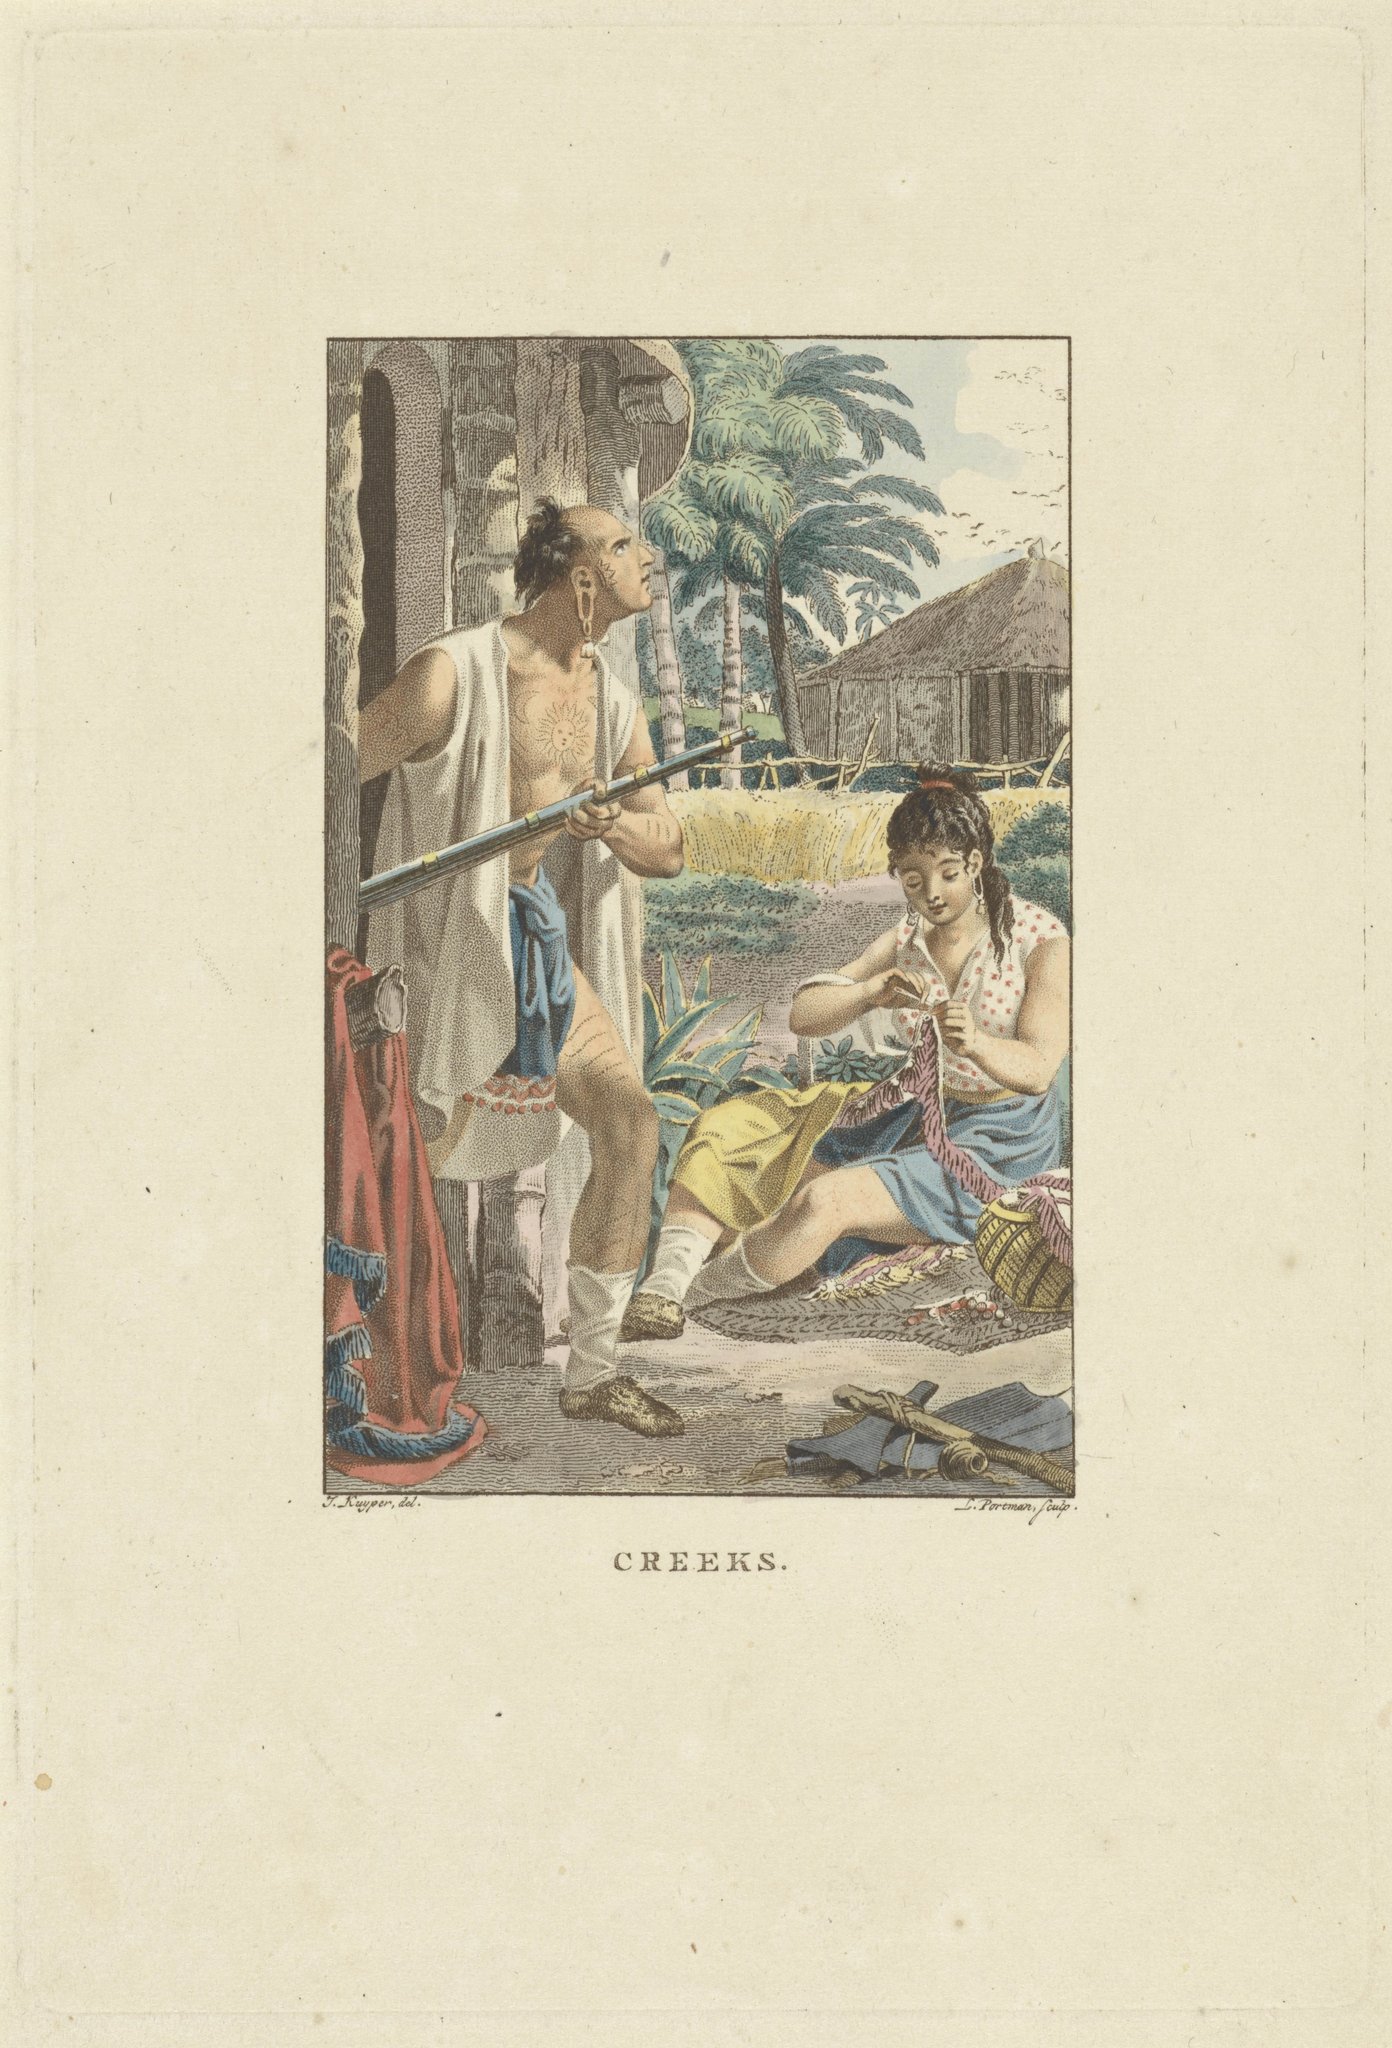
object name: book illustration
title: Echtpaar bij hun hut in het veld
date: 1805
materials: paper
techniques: brush, etching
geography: amsterdam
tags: indigenous peoples of north america, bird hunting, human races; peoples; nationalities (+ costume), sewing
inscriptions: collector's mark: Lugt 2228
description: Illustratie uit: Stuart, Martinus. De mensch, zoo als hij voorkomt op den bekenden aardbol, deel IV, p. 114. Amsterdam: Johannes Allart, 1805.